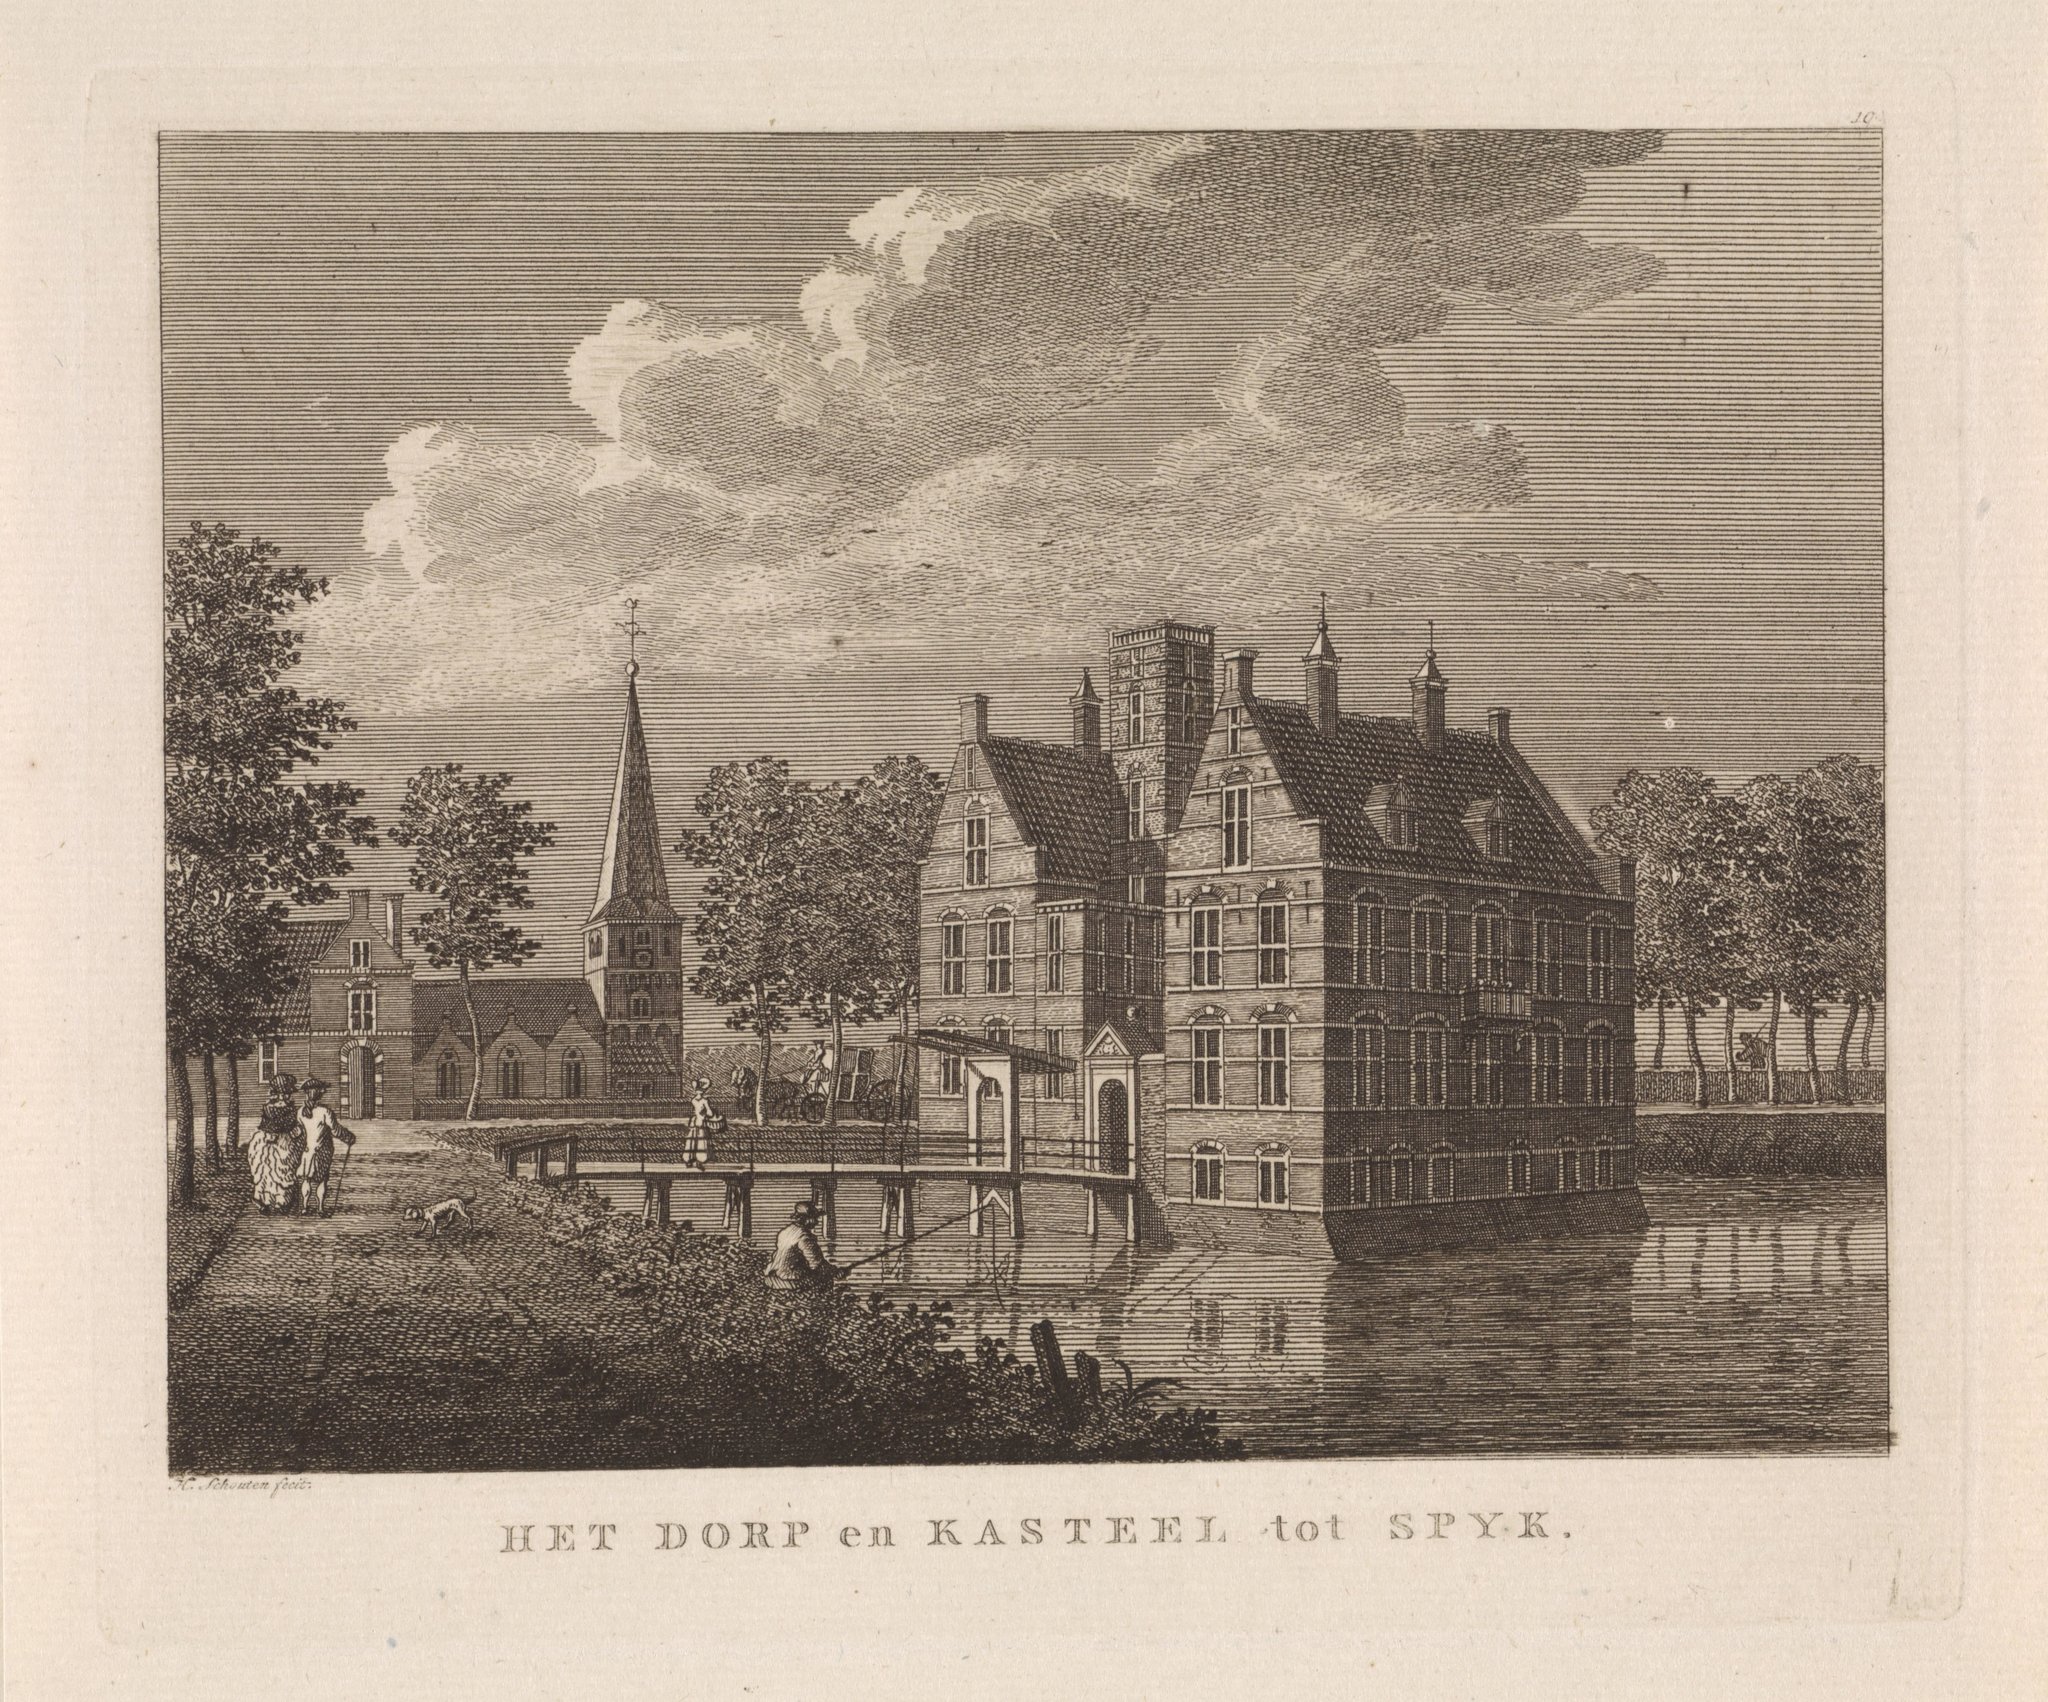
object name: print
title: Gezicht op het kasteel te Spijk (Lingewaal)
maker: hermanus petrus schouten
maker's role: draughtsman, painter, print maker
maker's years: 1747-1822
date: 1762-1822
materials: paper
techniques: etching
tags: spijk (lingewaal)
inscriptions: collector's mark: Lugt 2228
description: Gezicht op het kasteel en de kerk te Spijk (Lingewaal). Rechtsboven genummerd "10".